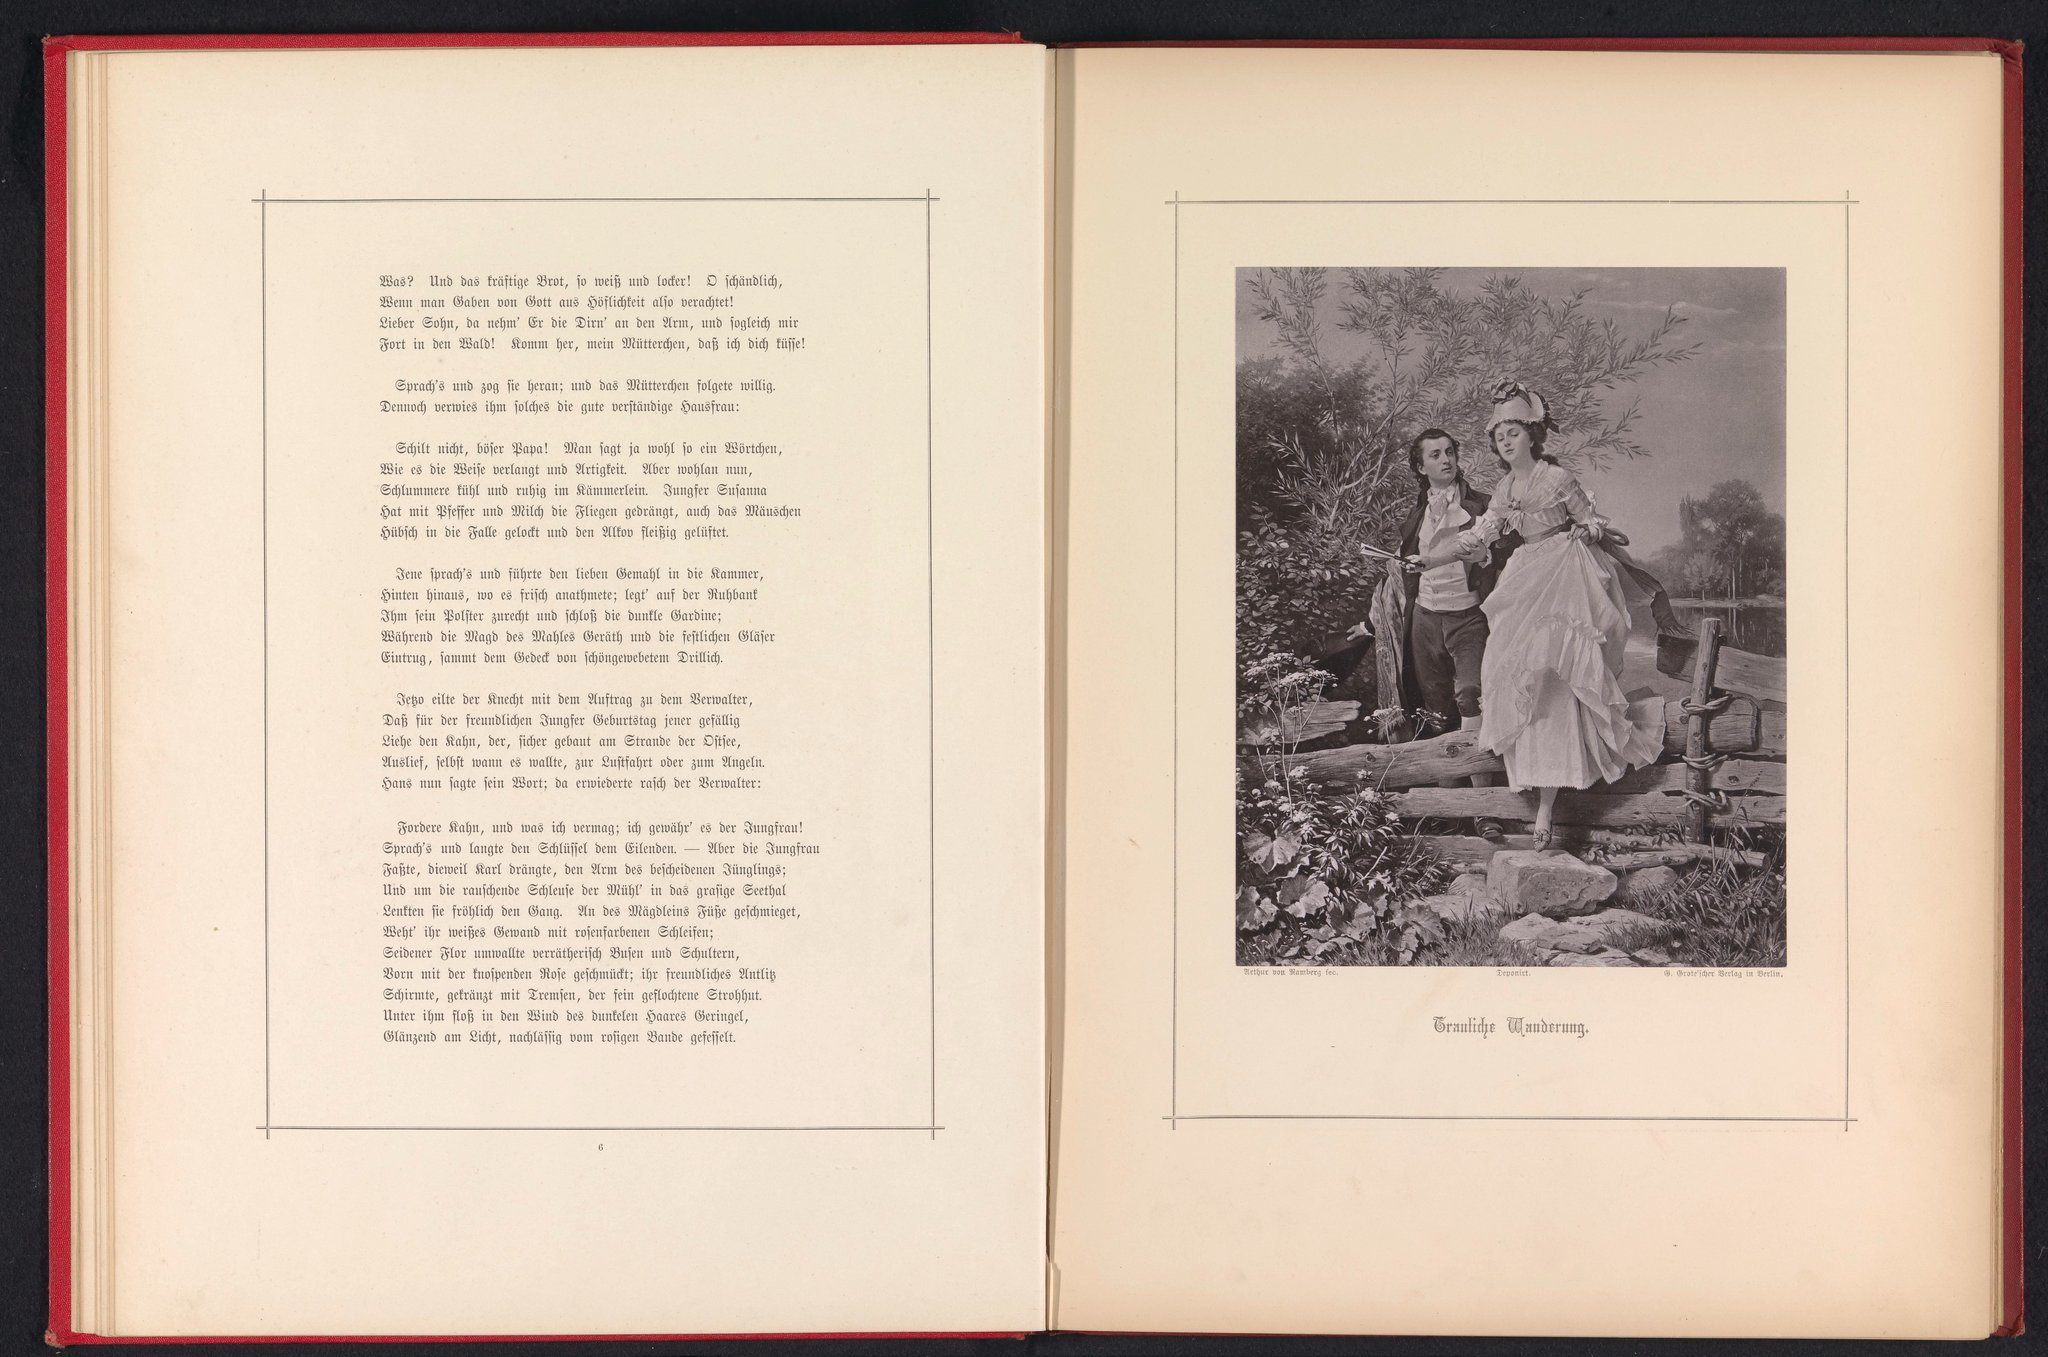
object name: reproduction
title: Fotoreproductie van een schilderij van een jonge man en vrouw die een houten hek passeren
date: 1874-1884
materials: paper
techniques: photograph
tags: adolescent, young woman, maiden, strolling, fence, wall, paling, youth, adolescent